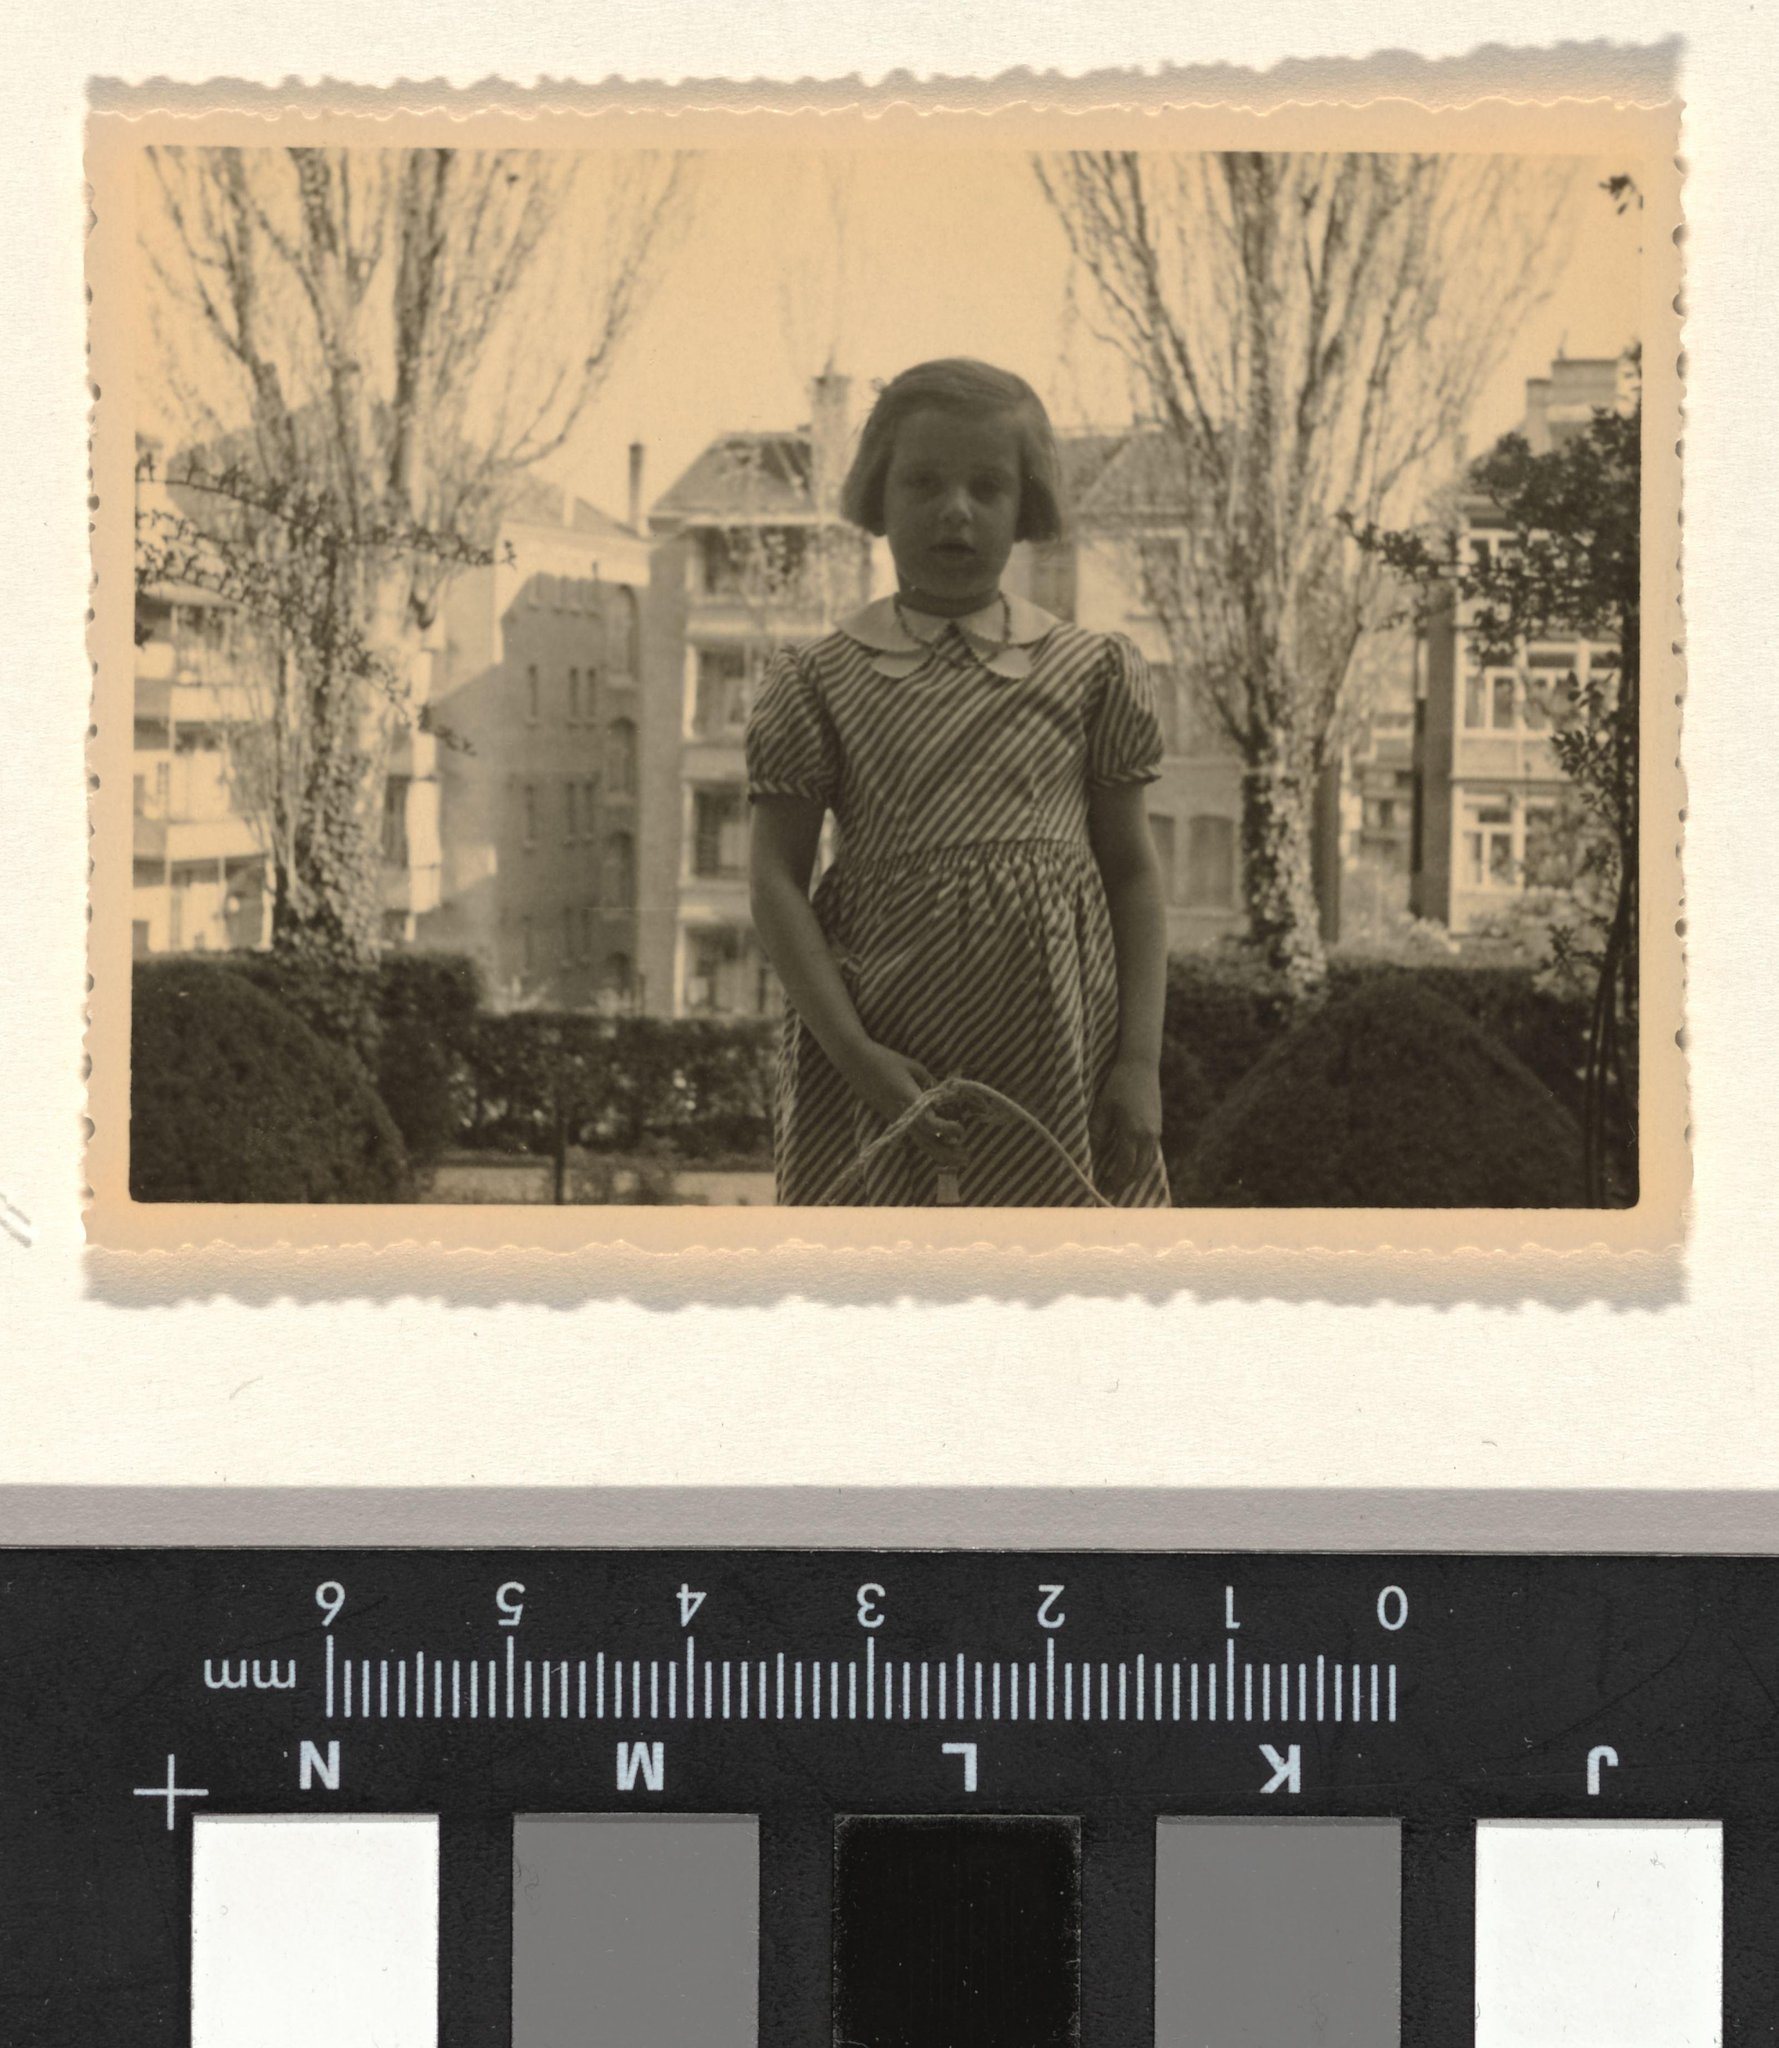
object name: photograph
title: Isabel Wachenheimer in gestreepte jurk voor huizenrij, april-mei 1935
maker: Anonymous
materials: photographic support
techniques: gelatin silver print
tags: leiden, isabel wachenheimer-elon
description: Isabel Wachenheimer in gestreepte jruk voor huizenrij.